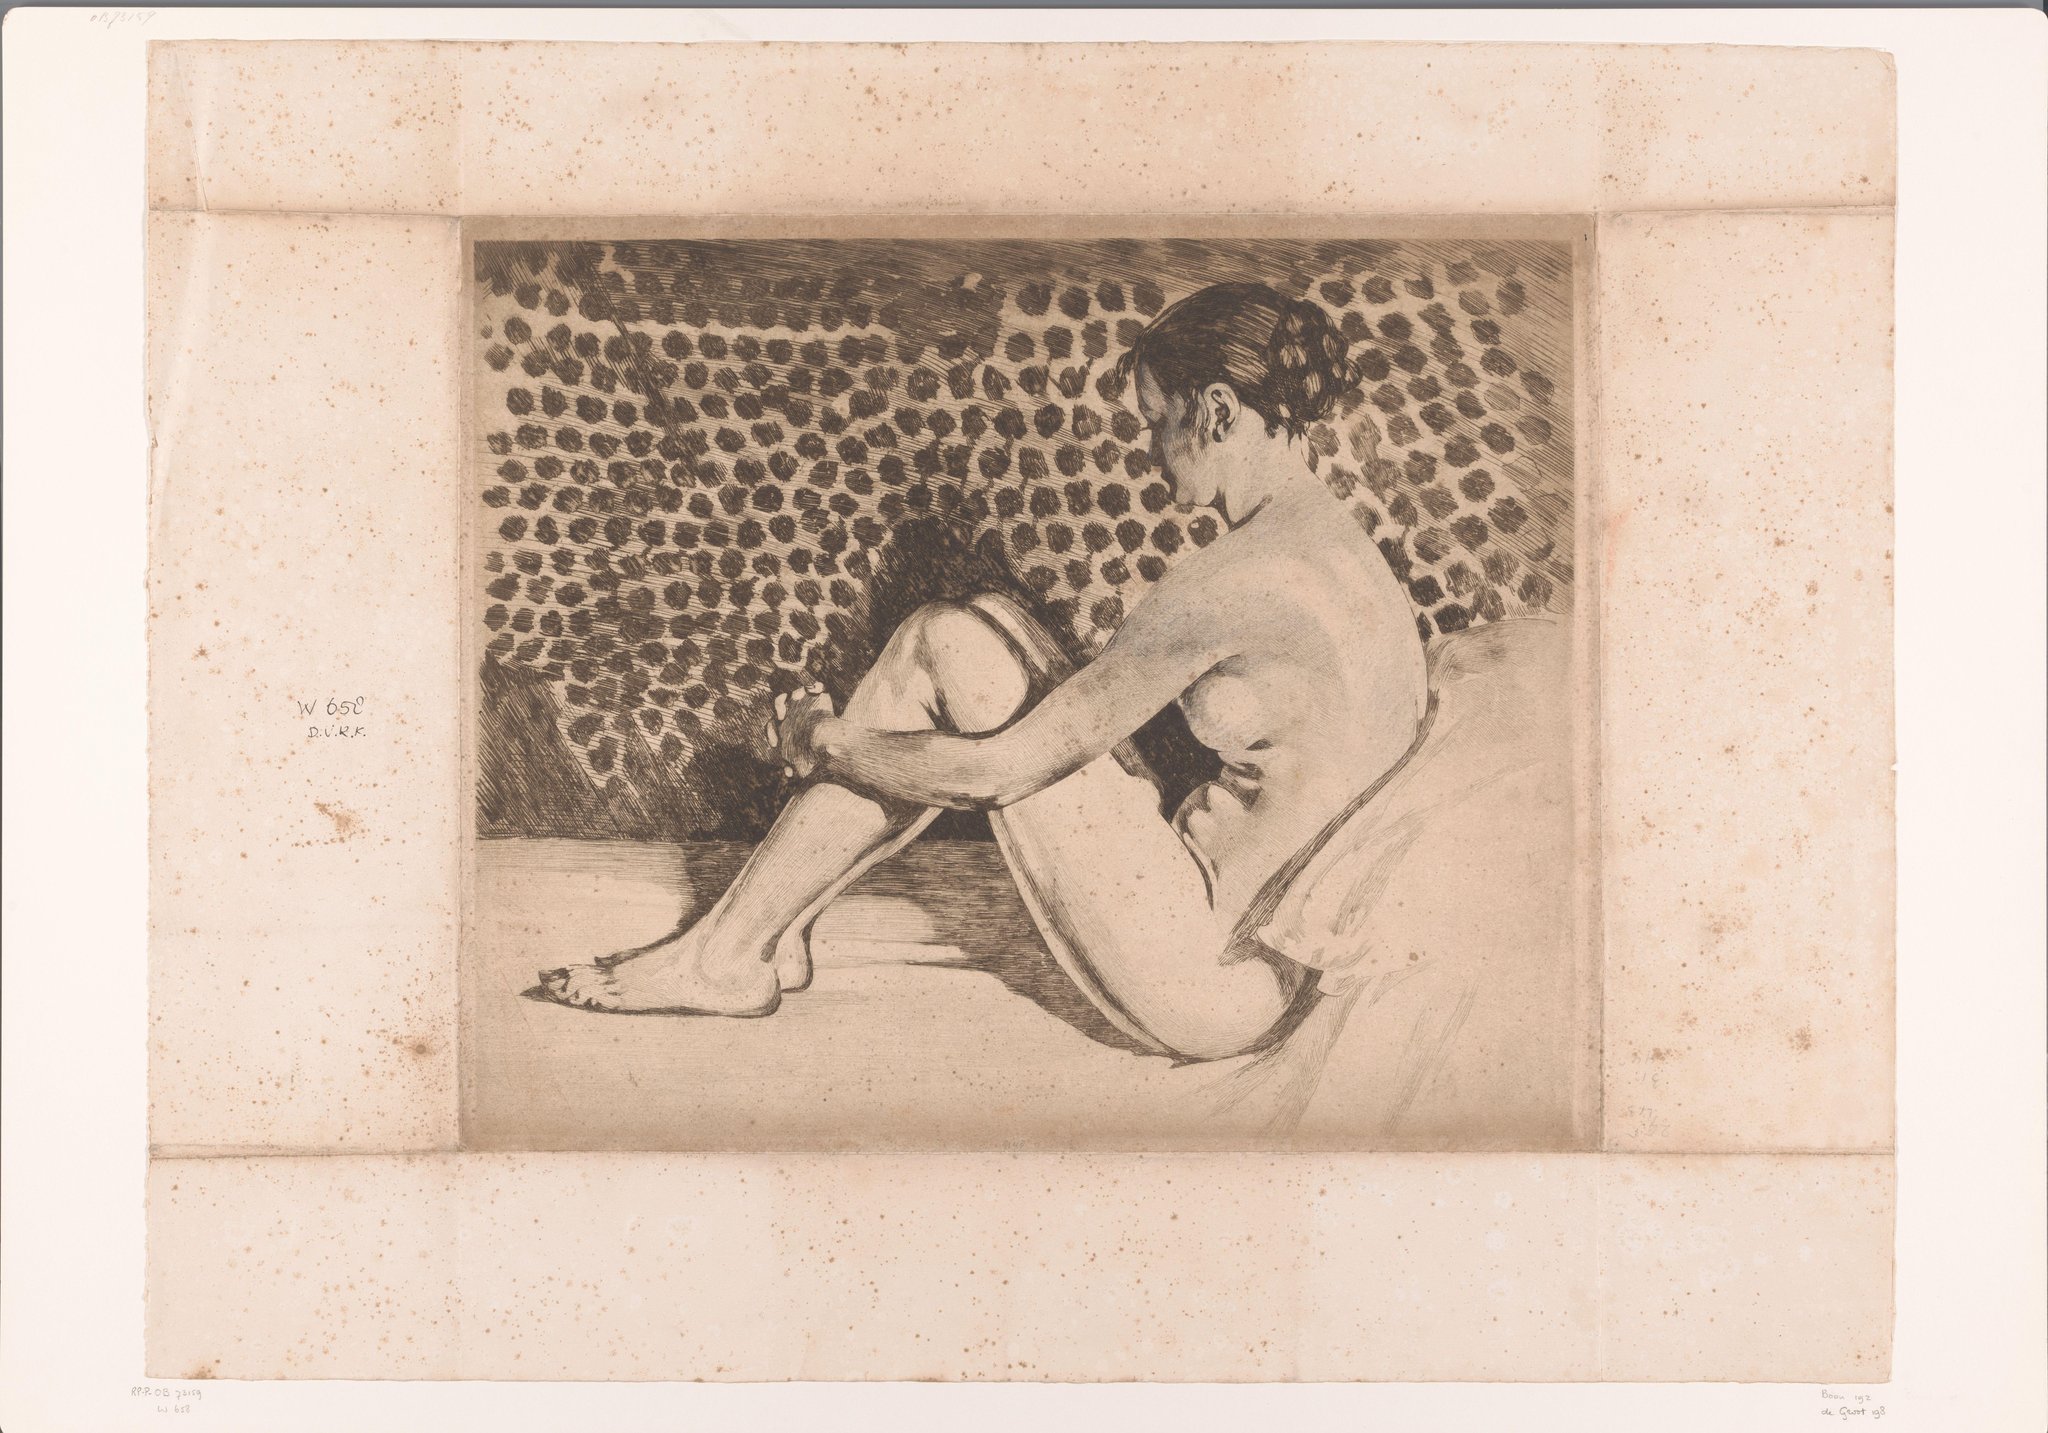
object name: print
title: Naakte vrouw met opgetrokken knieën zittend op een divan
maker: willem witsen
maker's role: draughtsman, painter, print maker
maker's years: 1860-1923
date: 1870-1923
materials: paper, pencil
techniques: etching, intaglio, retroussage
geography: netherlands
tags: sitting or lying with bent legs drawn up or raised - aa - female human figure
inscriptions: collector's mark: Lugt 2228